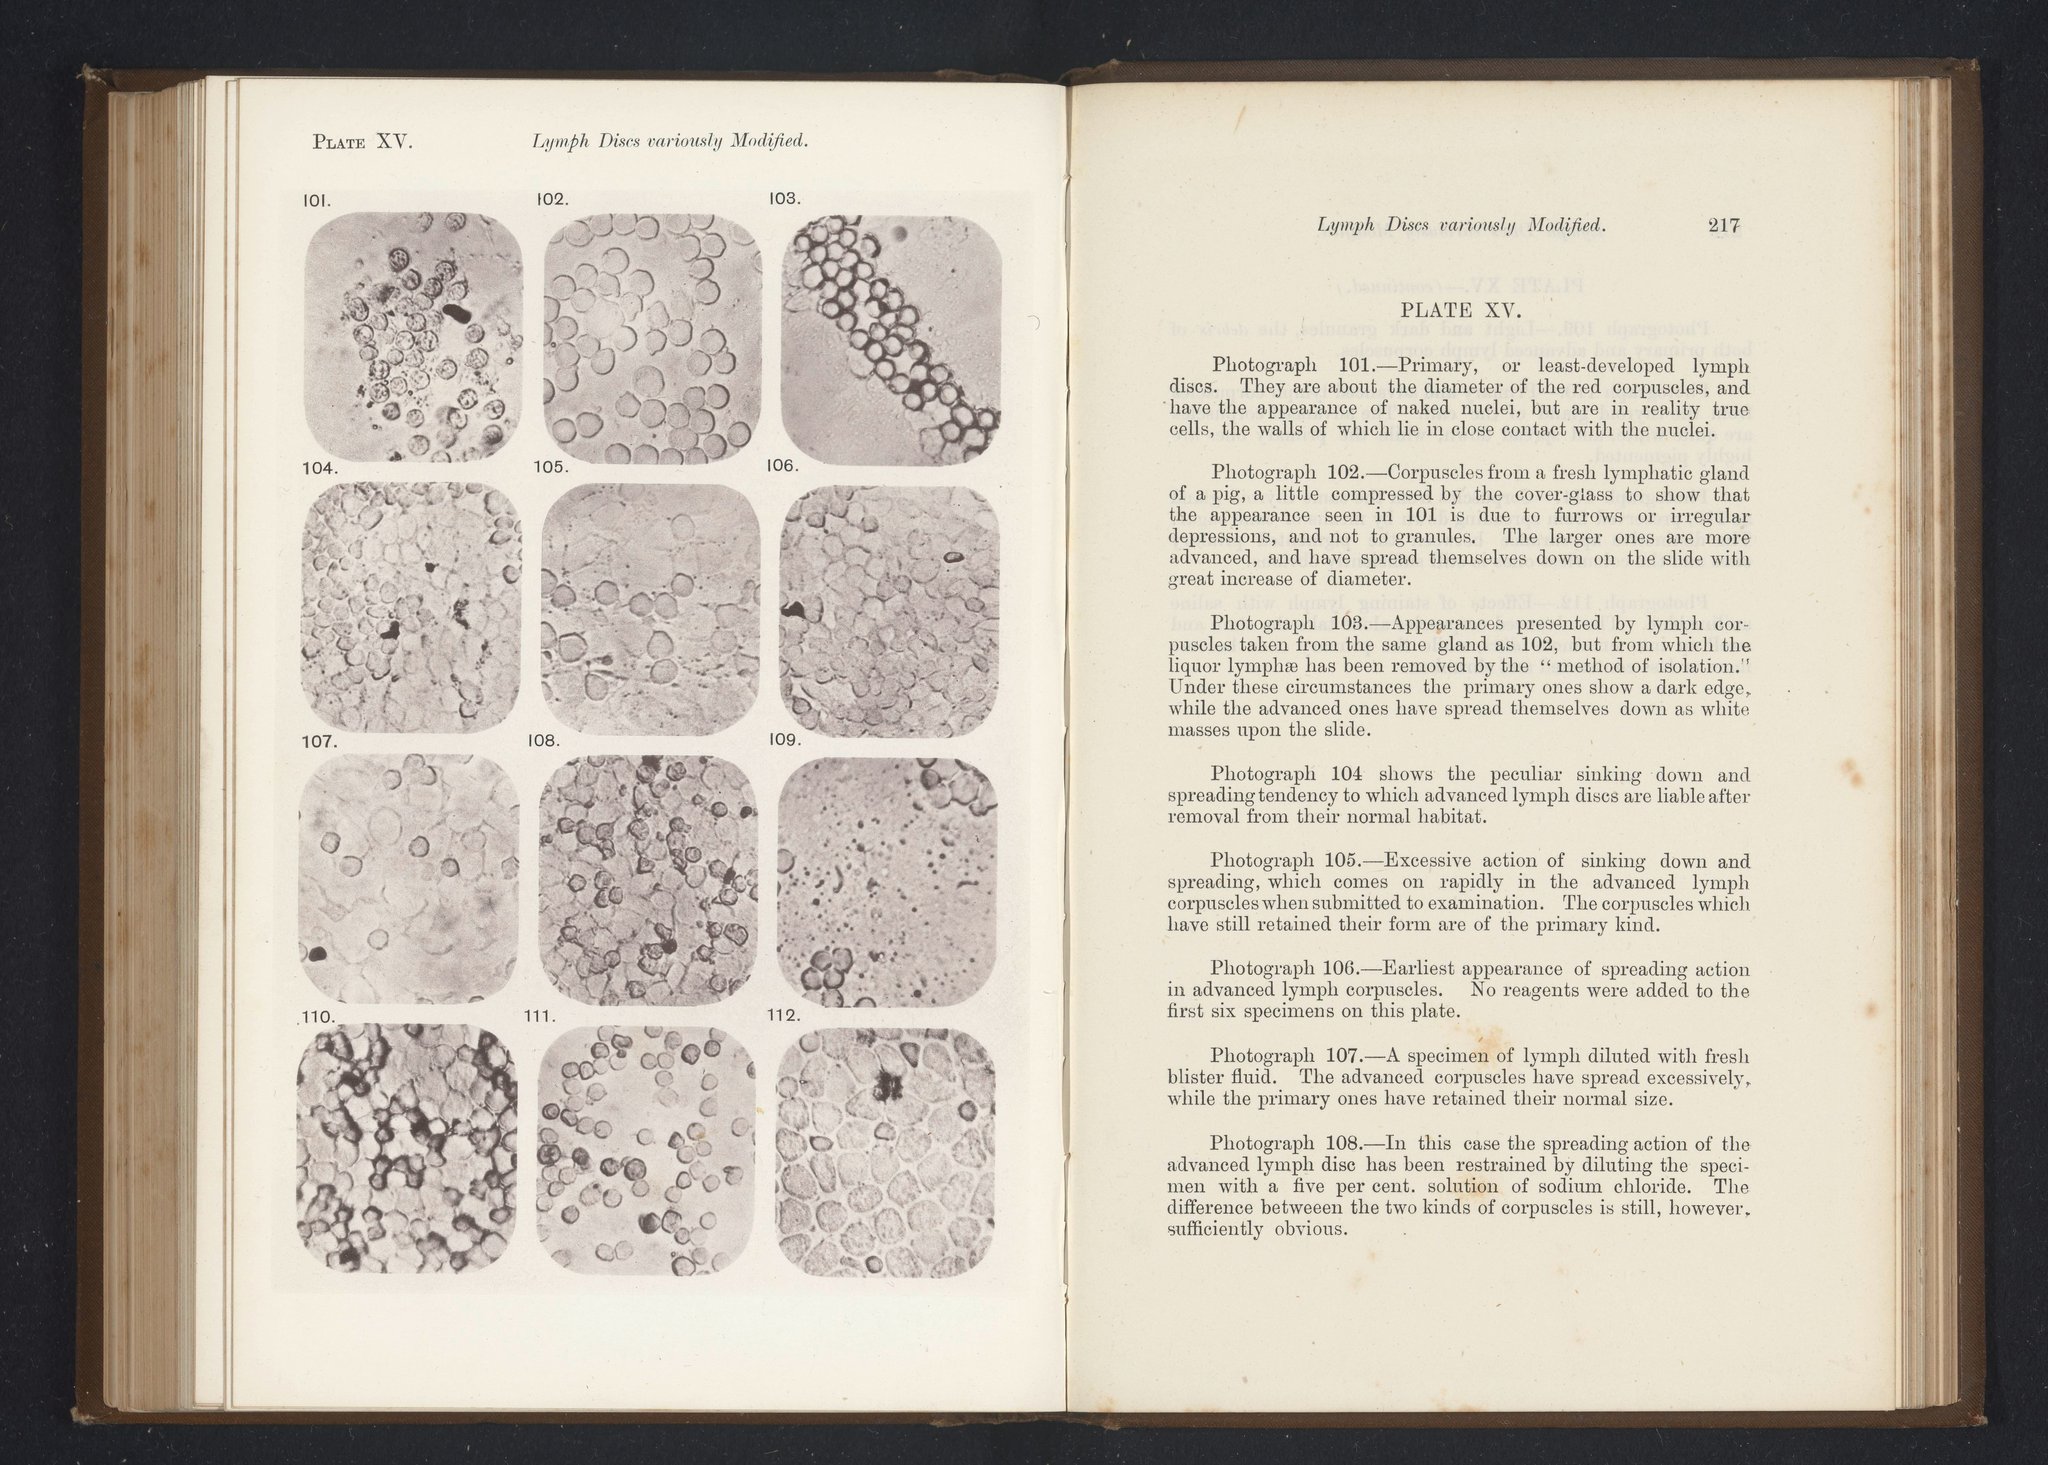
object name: photomechanical print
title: Twaalf vergrotingen van lymfocyten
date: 1872-1882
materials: paper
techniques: photograph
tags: blood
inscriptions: number: ‘Photo. 101. (...) Photo. 112.’, number: ‘Pl. XV.’